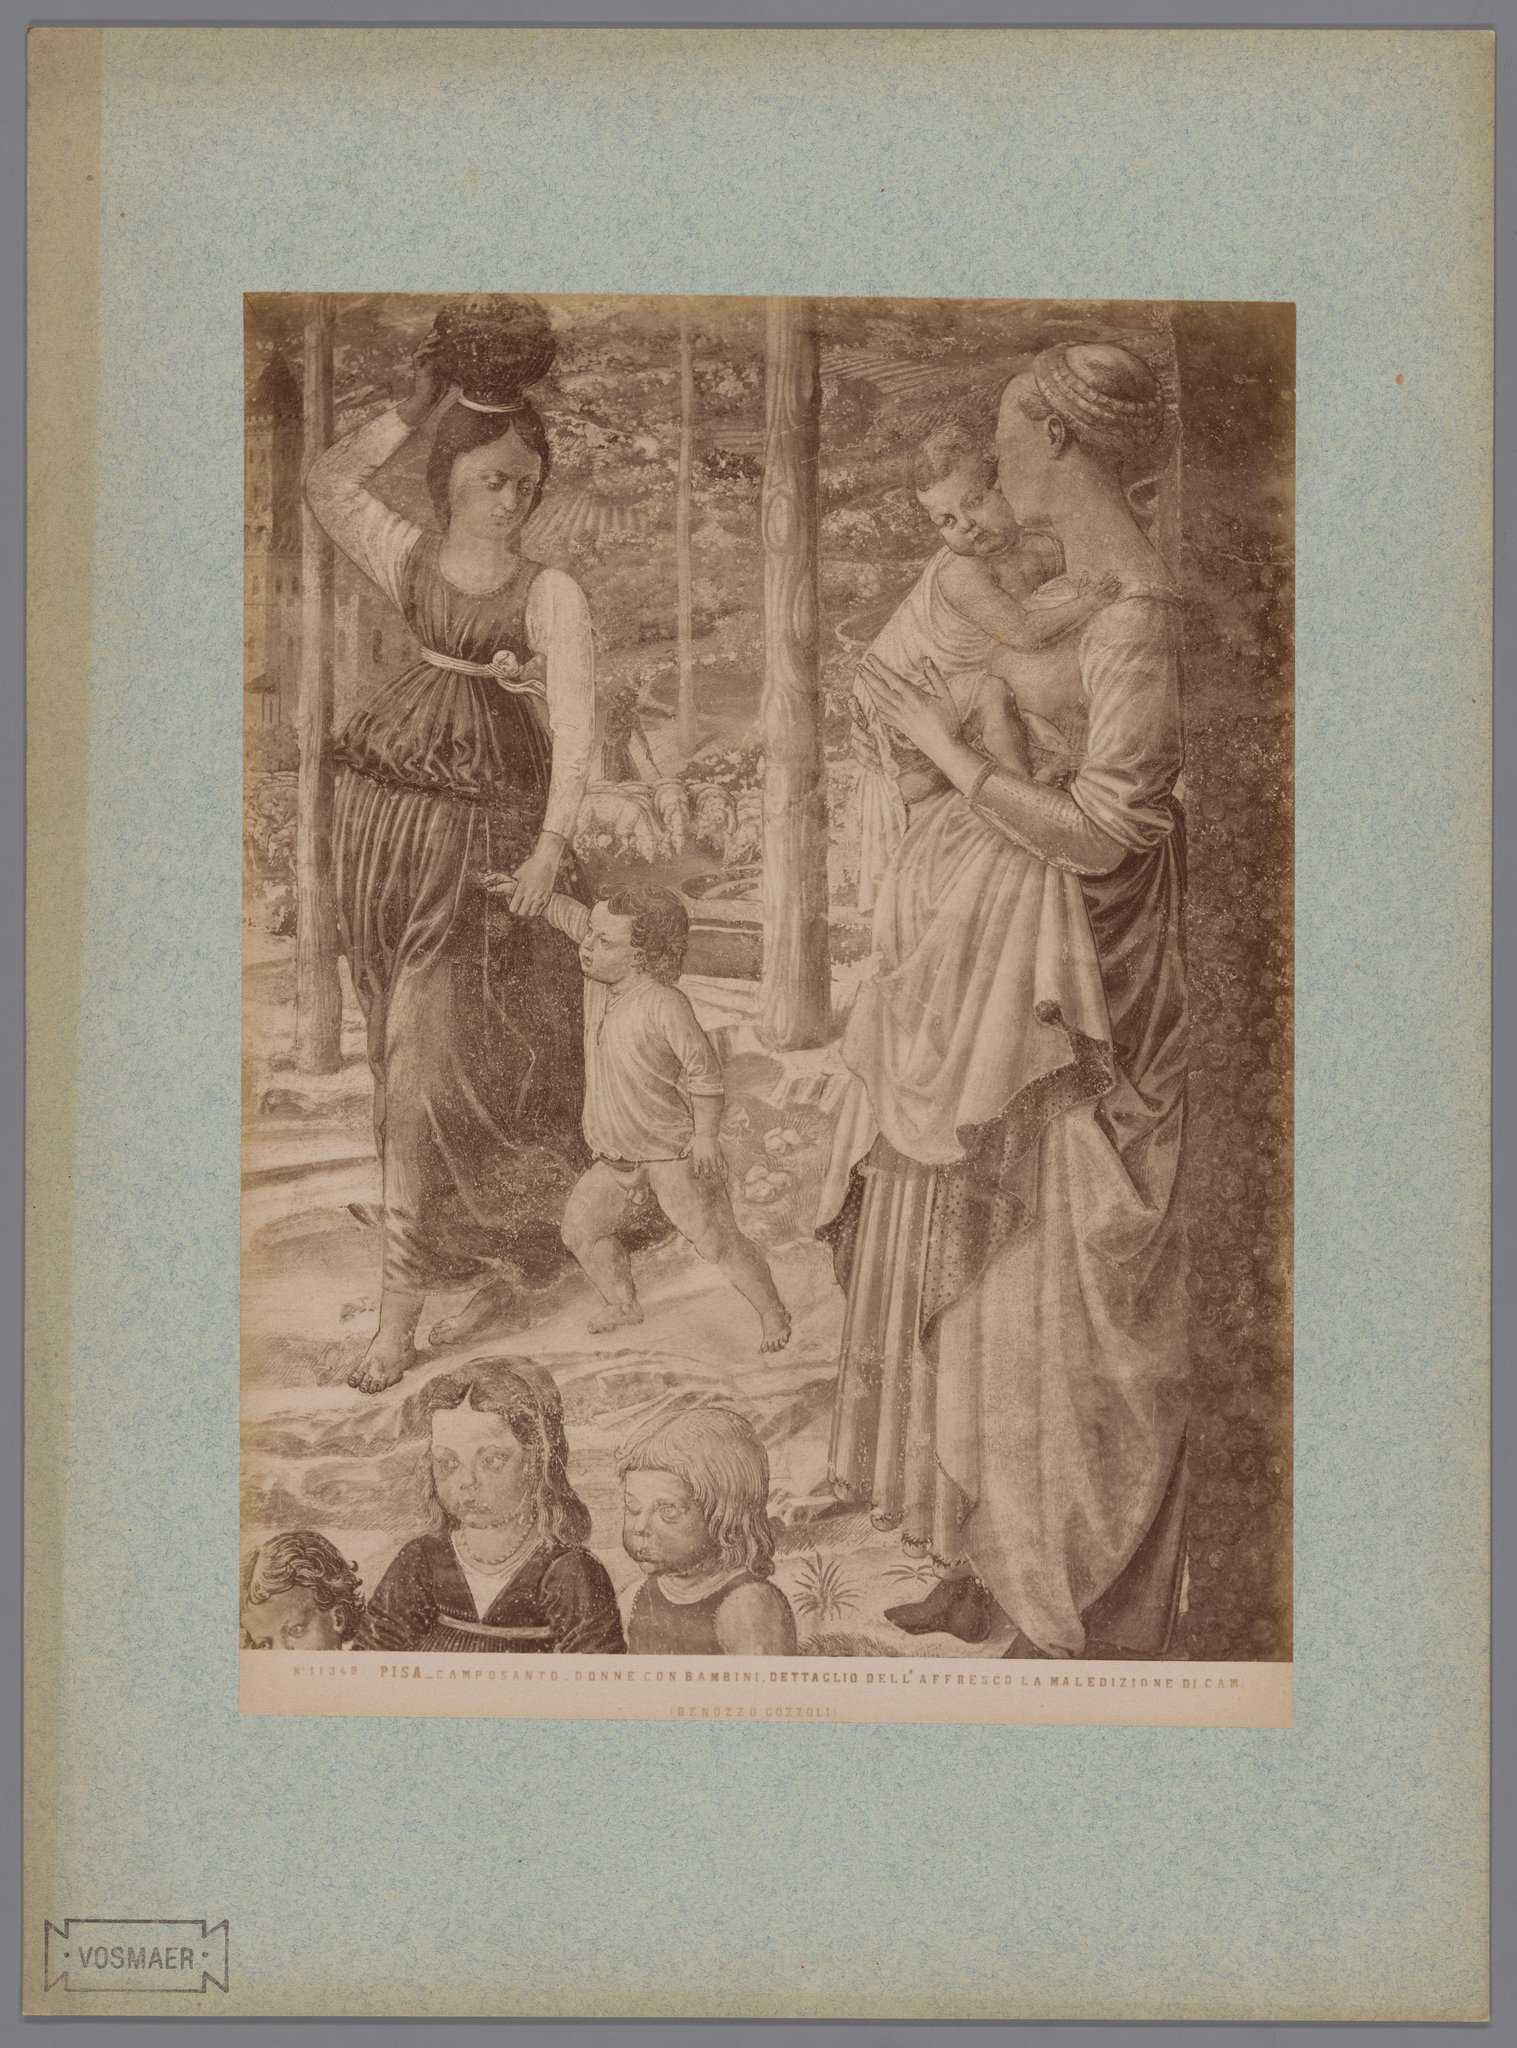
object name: reproduction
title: Camposanto. Donne con Bambini, dettaglio dell'affresco La Maledizione di Cam. (Benozzo Gozzoli)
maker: benozzo gozzoli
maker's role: draughtsman, painter, sculptor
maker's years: 1421-1497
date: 1857-1900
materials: cardboard, paper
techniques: albumen print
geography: florence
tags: picture, painting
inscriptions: collector's mark: ‘VOSMAER’, number: ‘No. 11349’